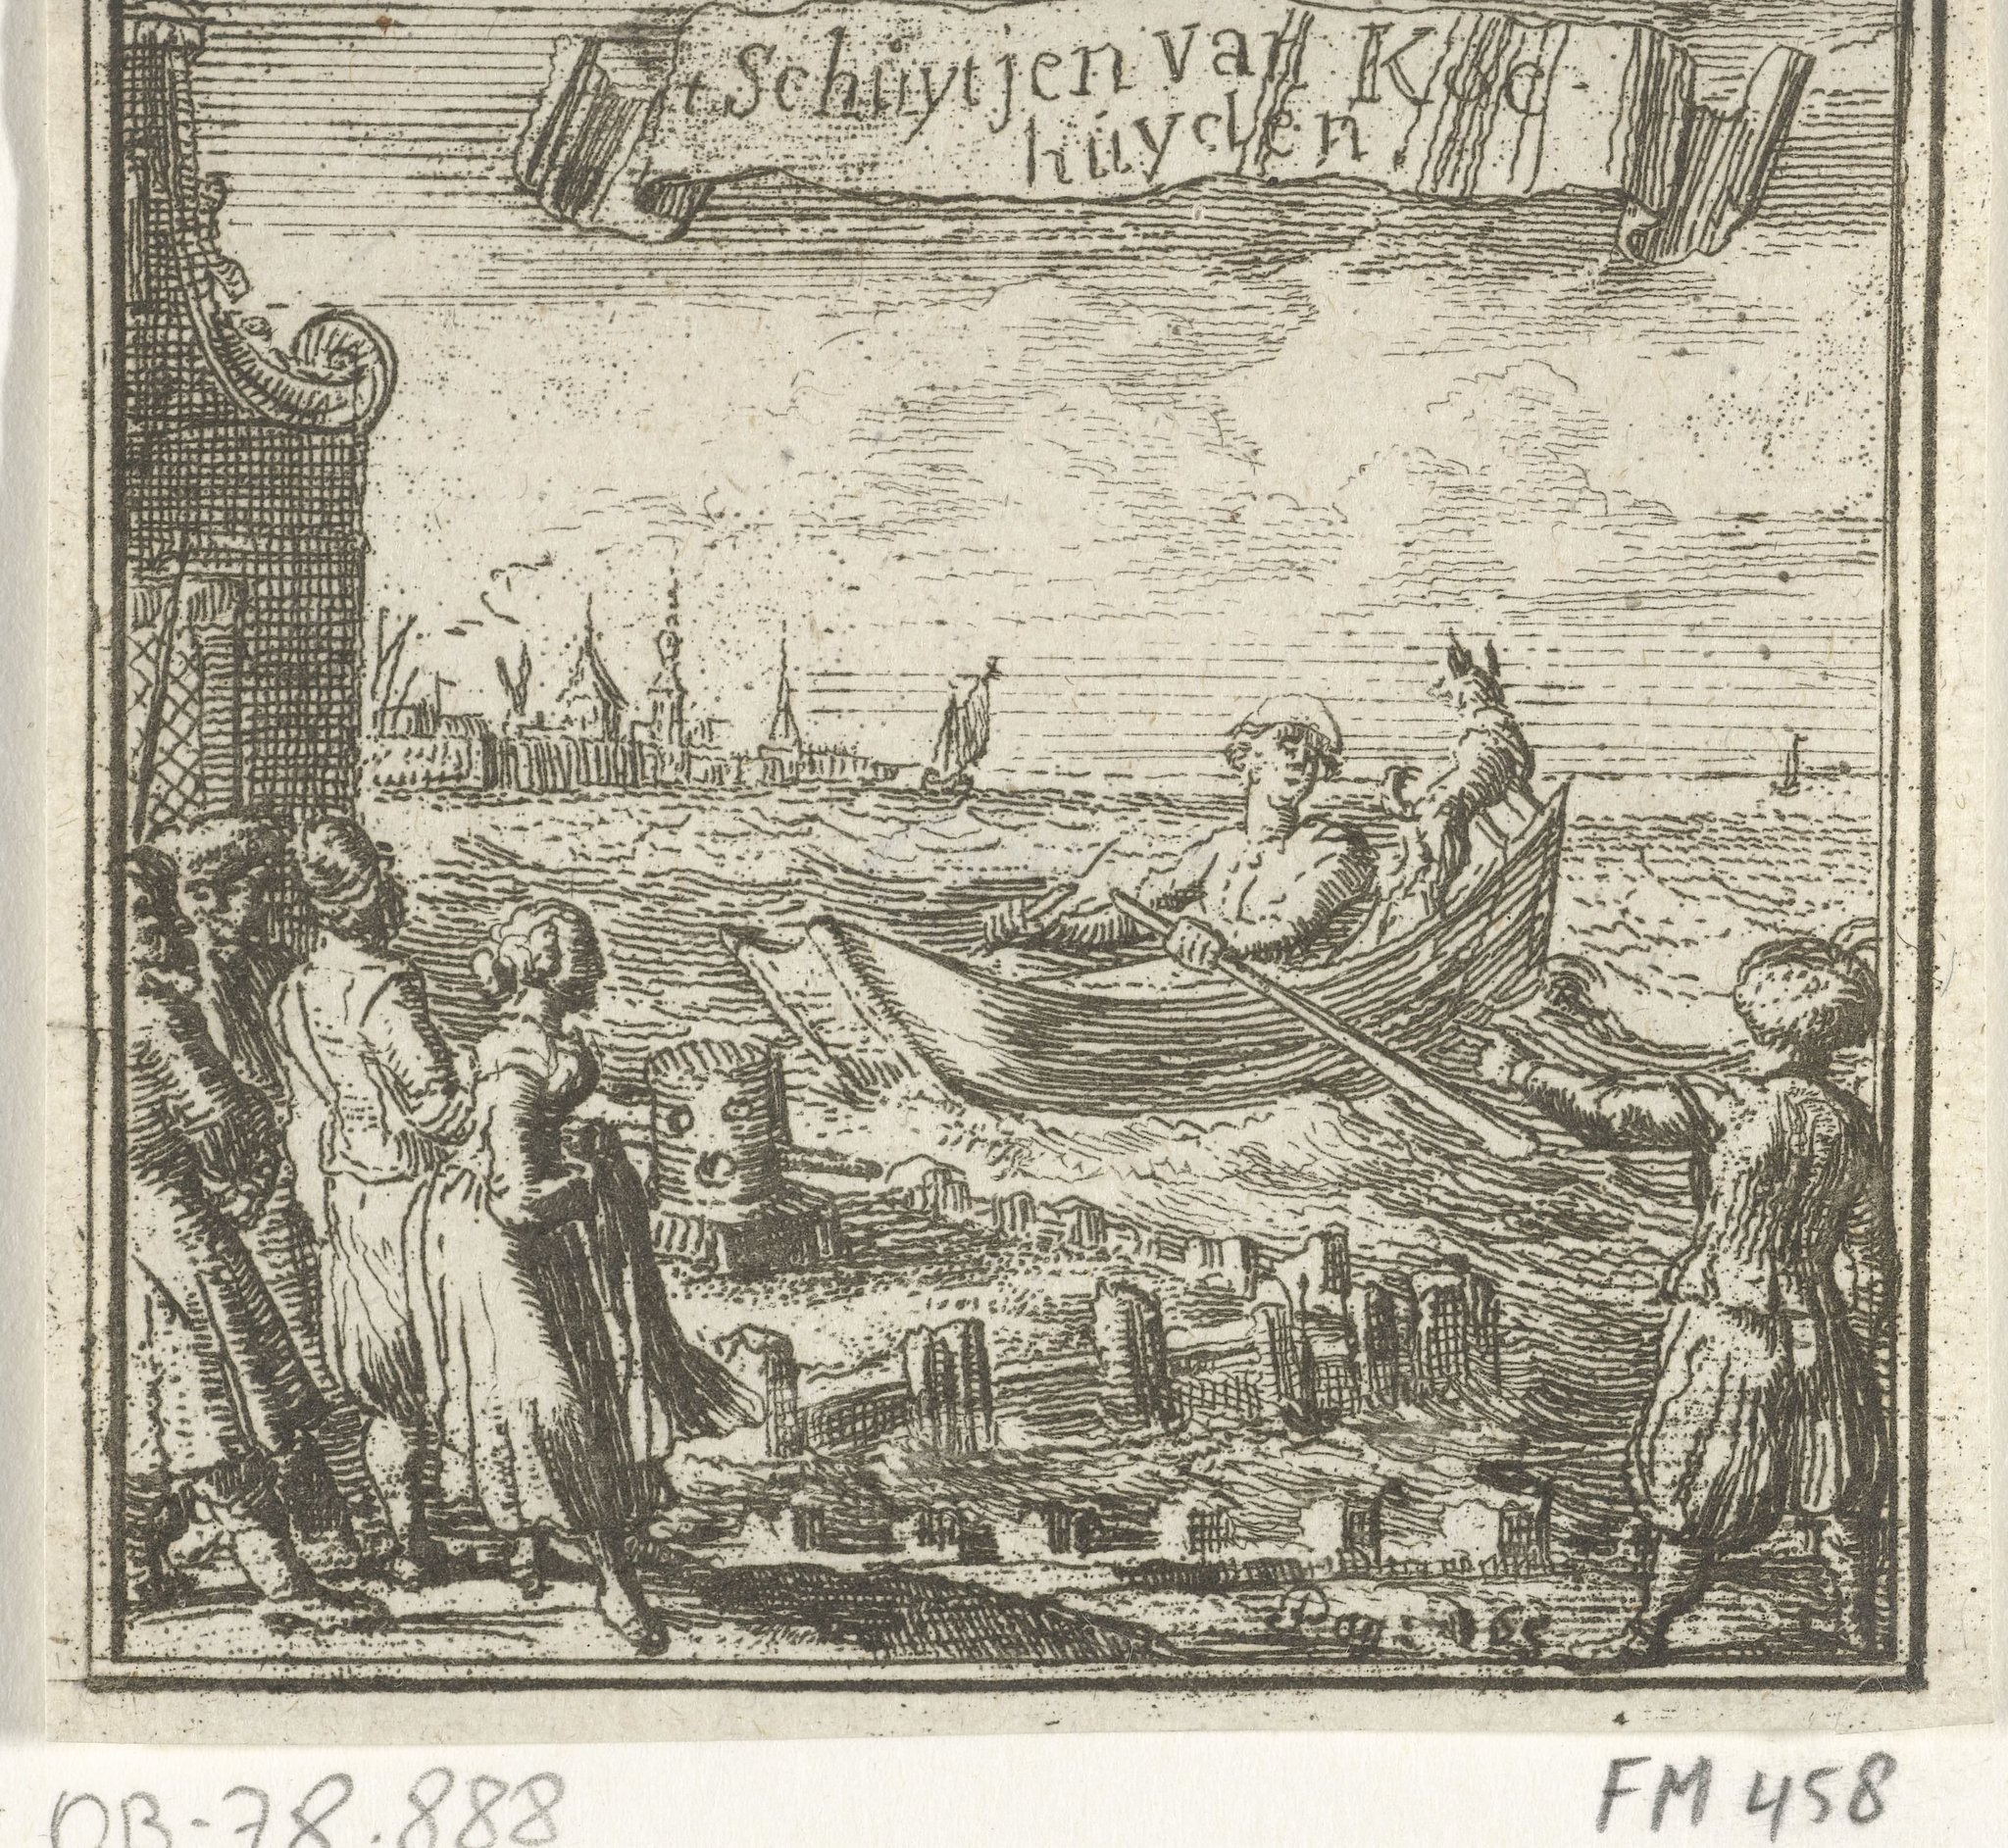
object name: history print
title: Vaart van Ellert Viscarn in een schuitje van koehuiden van Hoorn naar Danzig, 1558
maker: romeyn de hooghe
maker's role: draughtsman, goldsmith, painter, print maker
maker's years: 1645-1708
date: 1704-1706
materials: paper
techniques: etching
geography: northern netherlands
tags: rowing-boat, canoe, etc.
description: Vaart van Ellert of Ellerd Viscarn, alias De Graaf, in een schuitje van vier koehuiden van Hoorn naar Dantzig, waar het scheepje door de koning van Polen gekocht en in de kerk te Krakow opgehangen zou zijn, 1558. Ellert arriveert roeiend bij Danzig aan de Poolse kust.